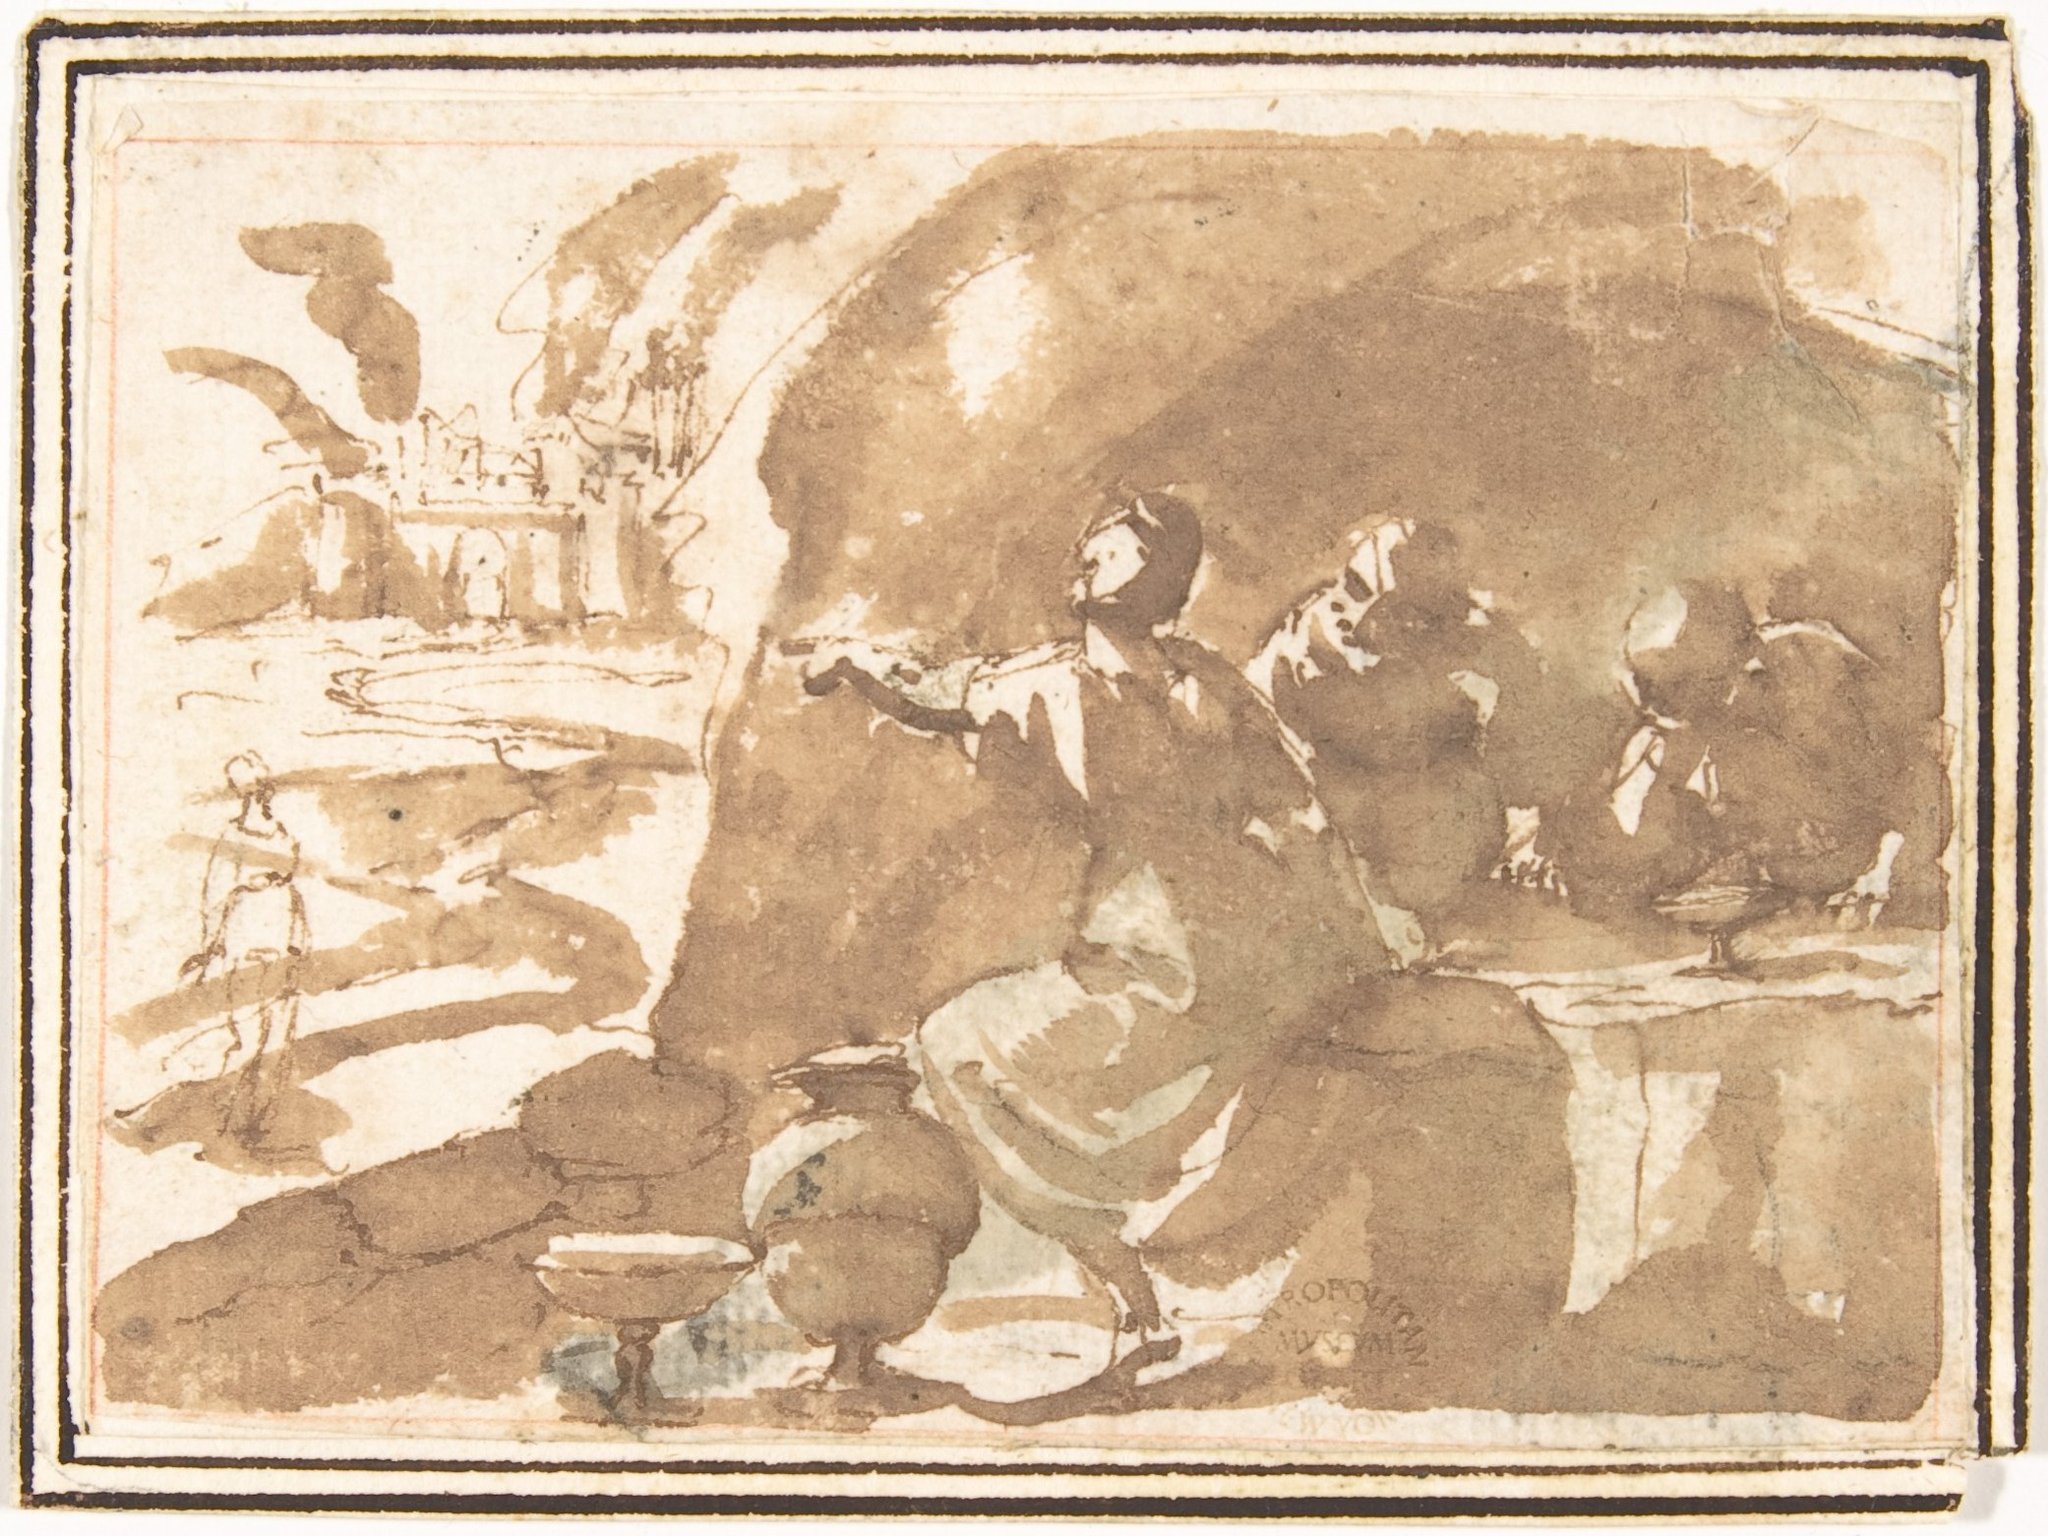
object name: drawing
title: Lot and His Daughters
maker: francesco allegrini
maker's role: artist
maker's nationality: italian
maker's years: 1615-1679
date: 1624-1663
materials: chalk, ink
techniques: brush, pen, wash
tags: girls,men